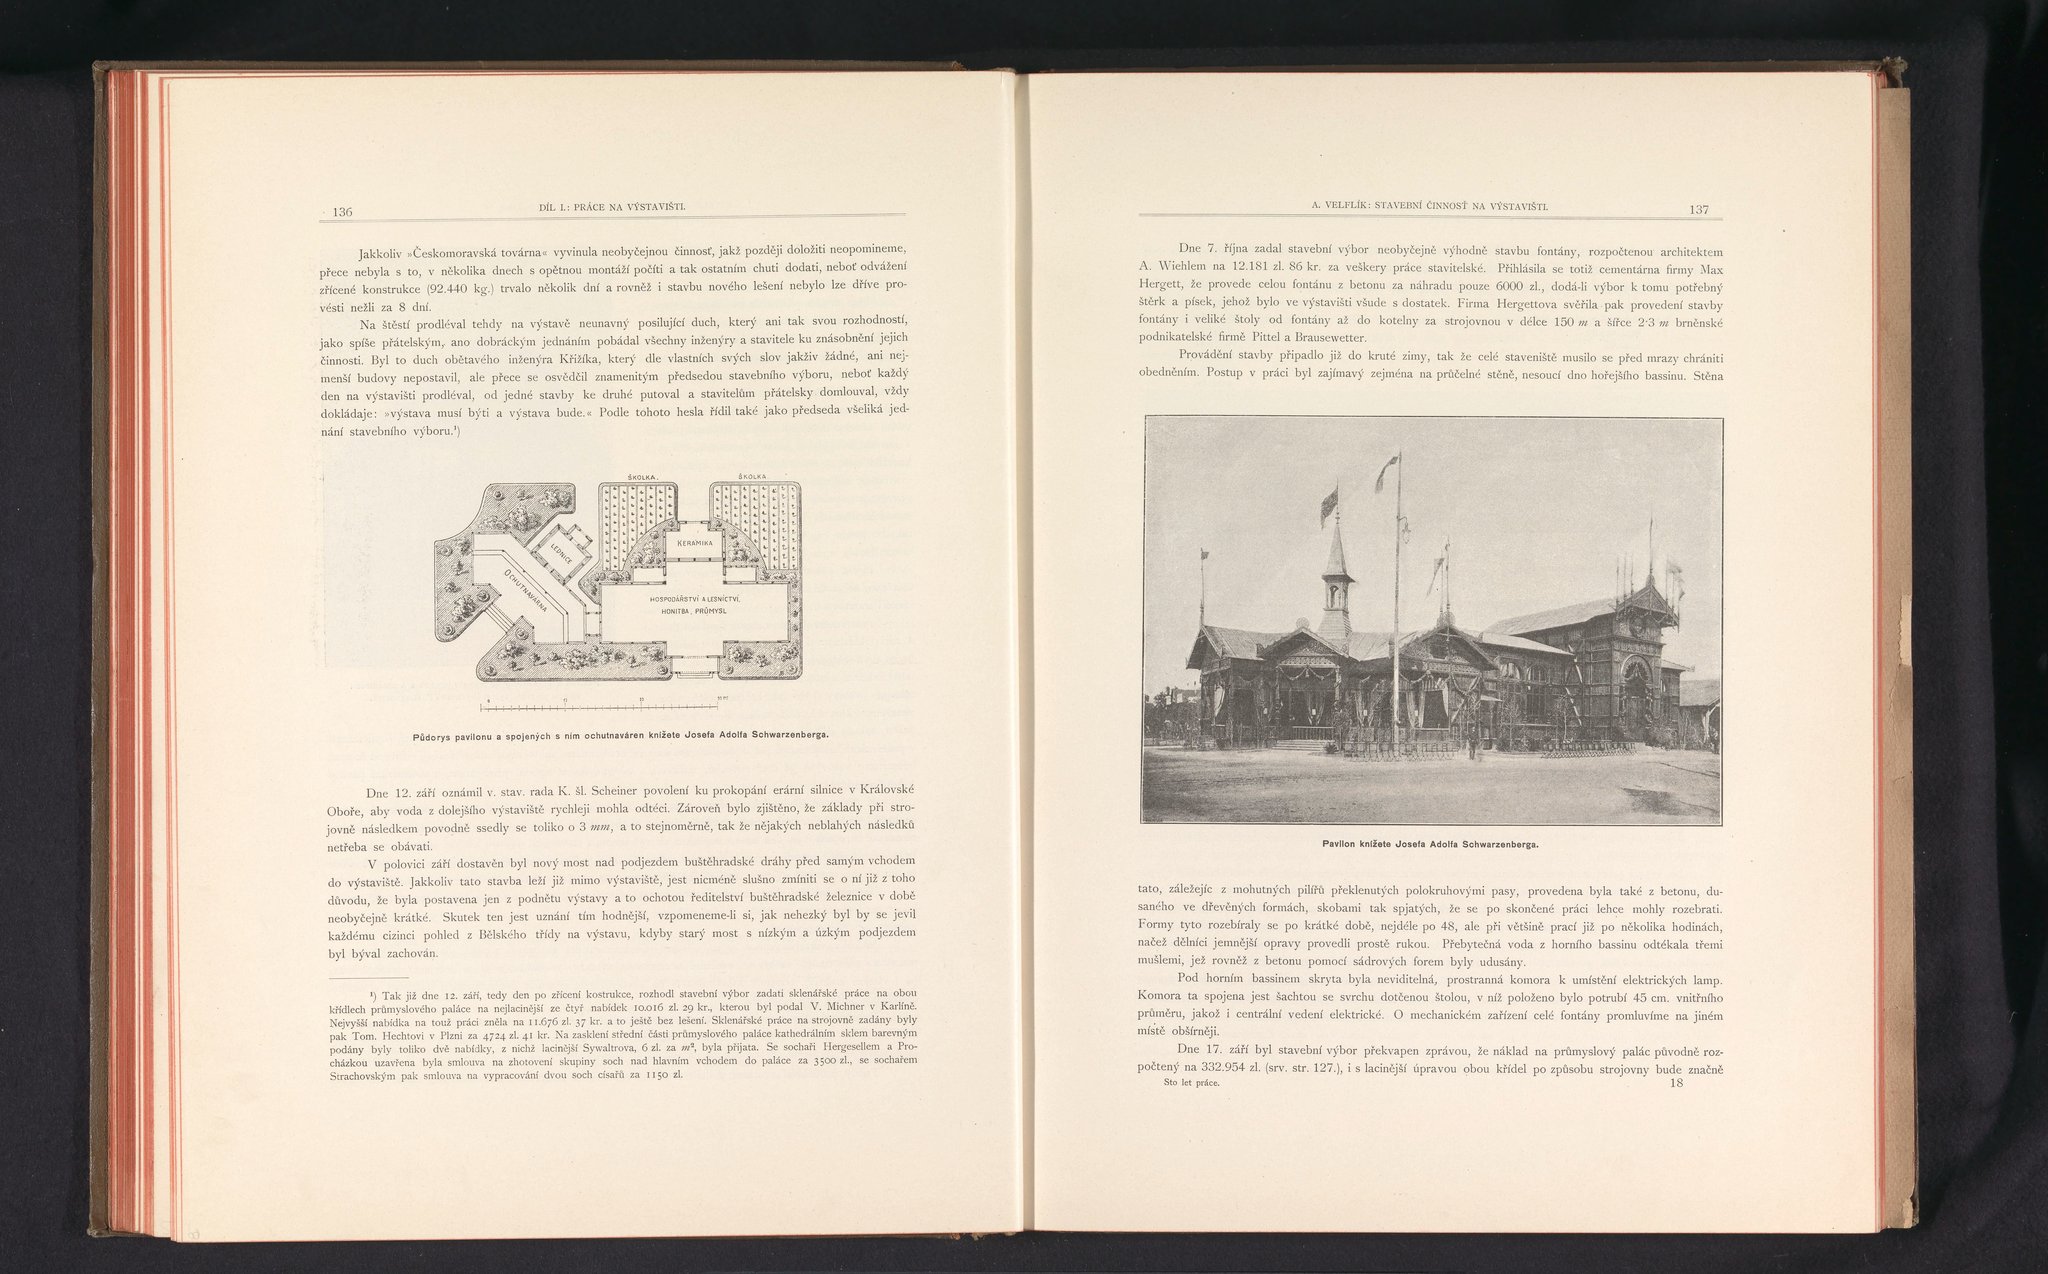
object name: photomechanical print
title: Pavilon knizete Josefa Adolfa schwarzenberge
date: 1888-1893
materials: paper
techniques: autotype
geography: výstaviště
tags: façade (of house or building), temporary exhibition, 'salon'